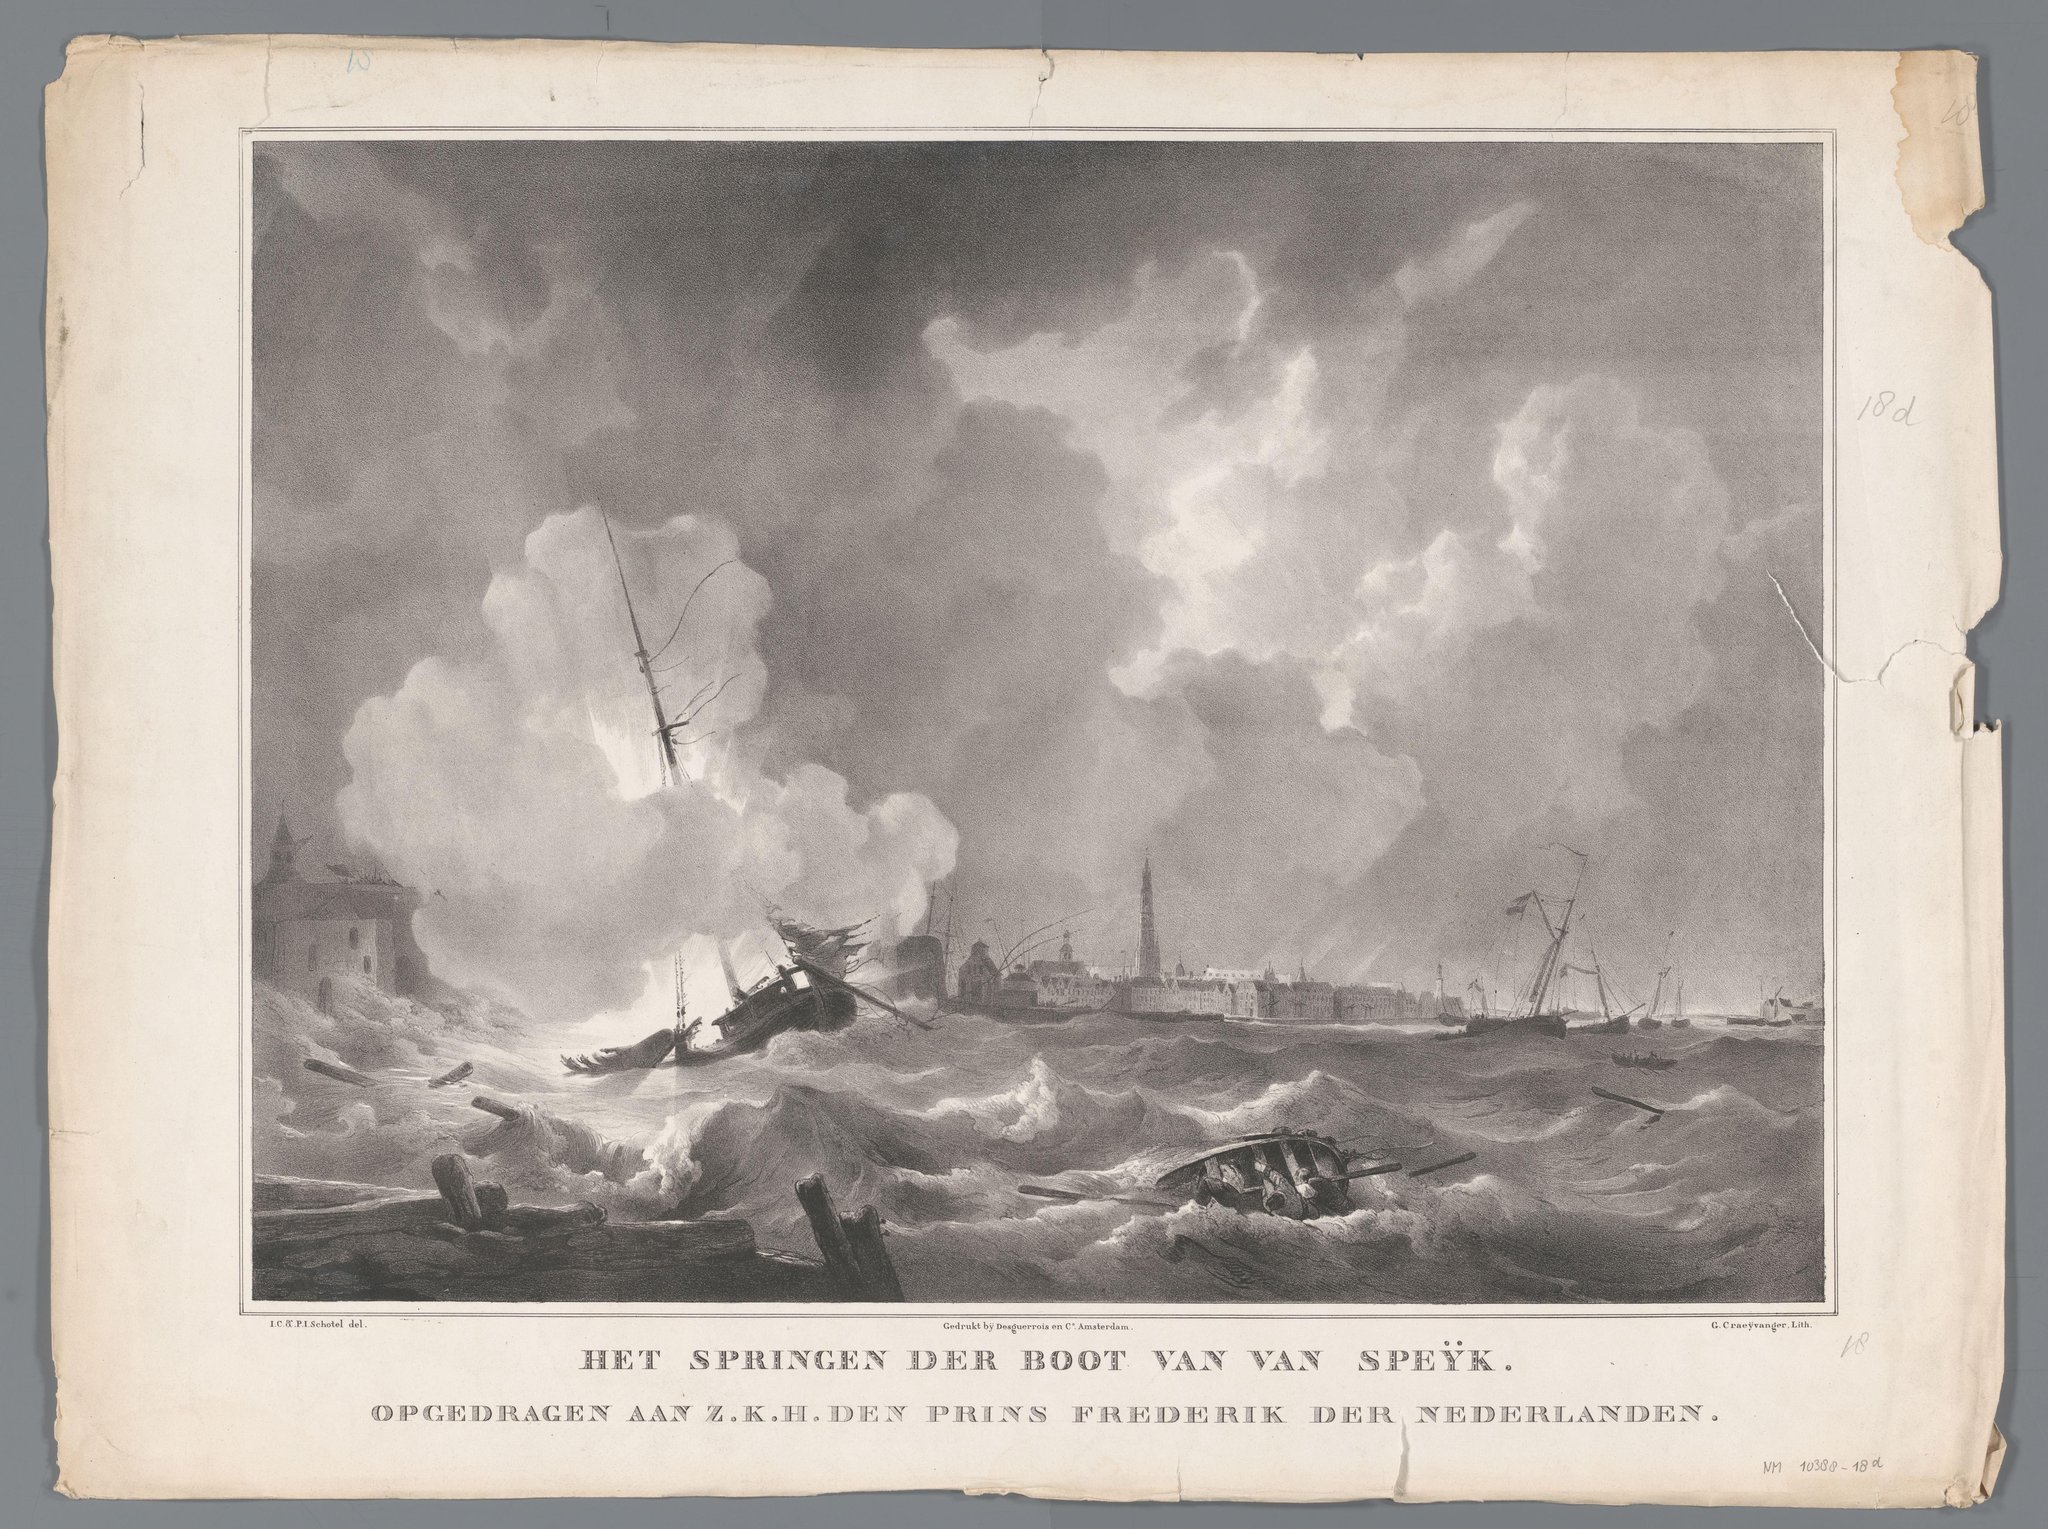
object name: print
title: Ontploffen van de boot van Jan van Speyk, 1831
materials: paper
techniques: lithograph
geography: amsterdam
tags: jan van speyk, navy (+ sailing-ships), self-sacrifice, death in the service of a higher purpose, gunpowder disaster, antwerp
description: Gezicht op de Schelde met links het in de lucht springen van de kanonneerboot van Jan van Speyk, 5 februari 1831. Op de voorgrond wordt een sloep die richting de kanonneerboot werd geroeid omvergeblazen. Zie ook de pendant.